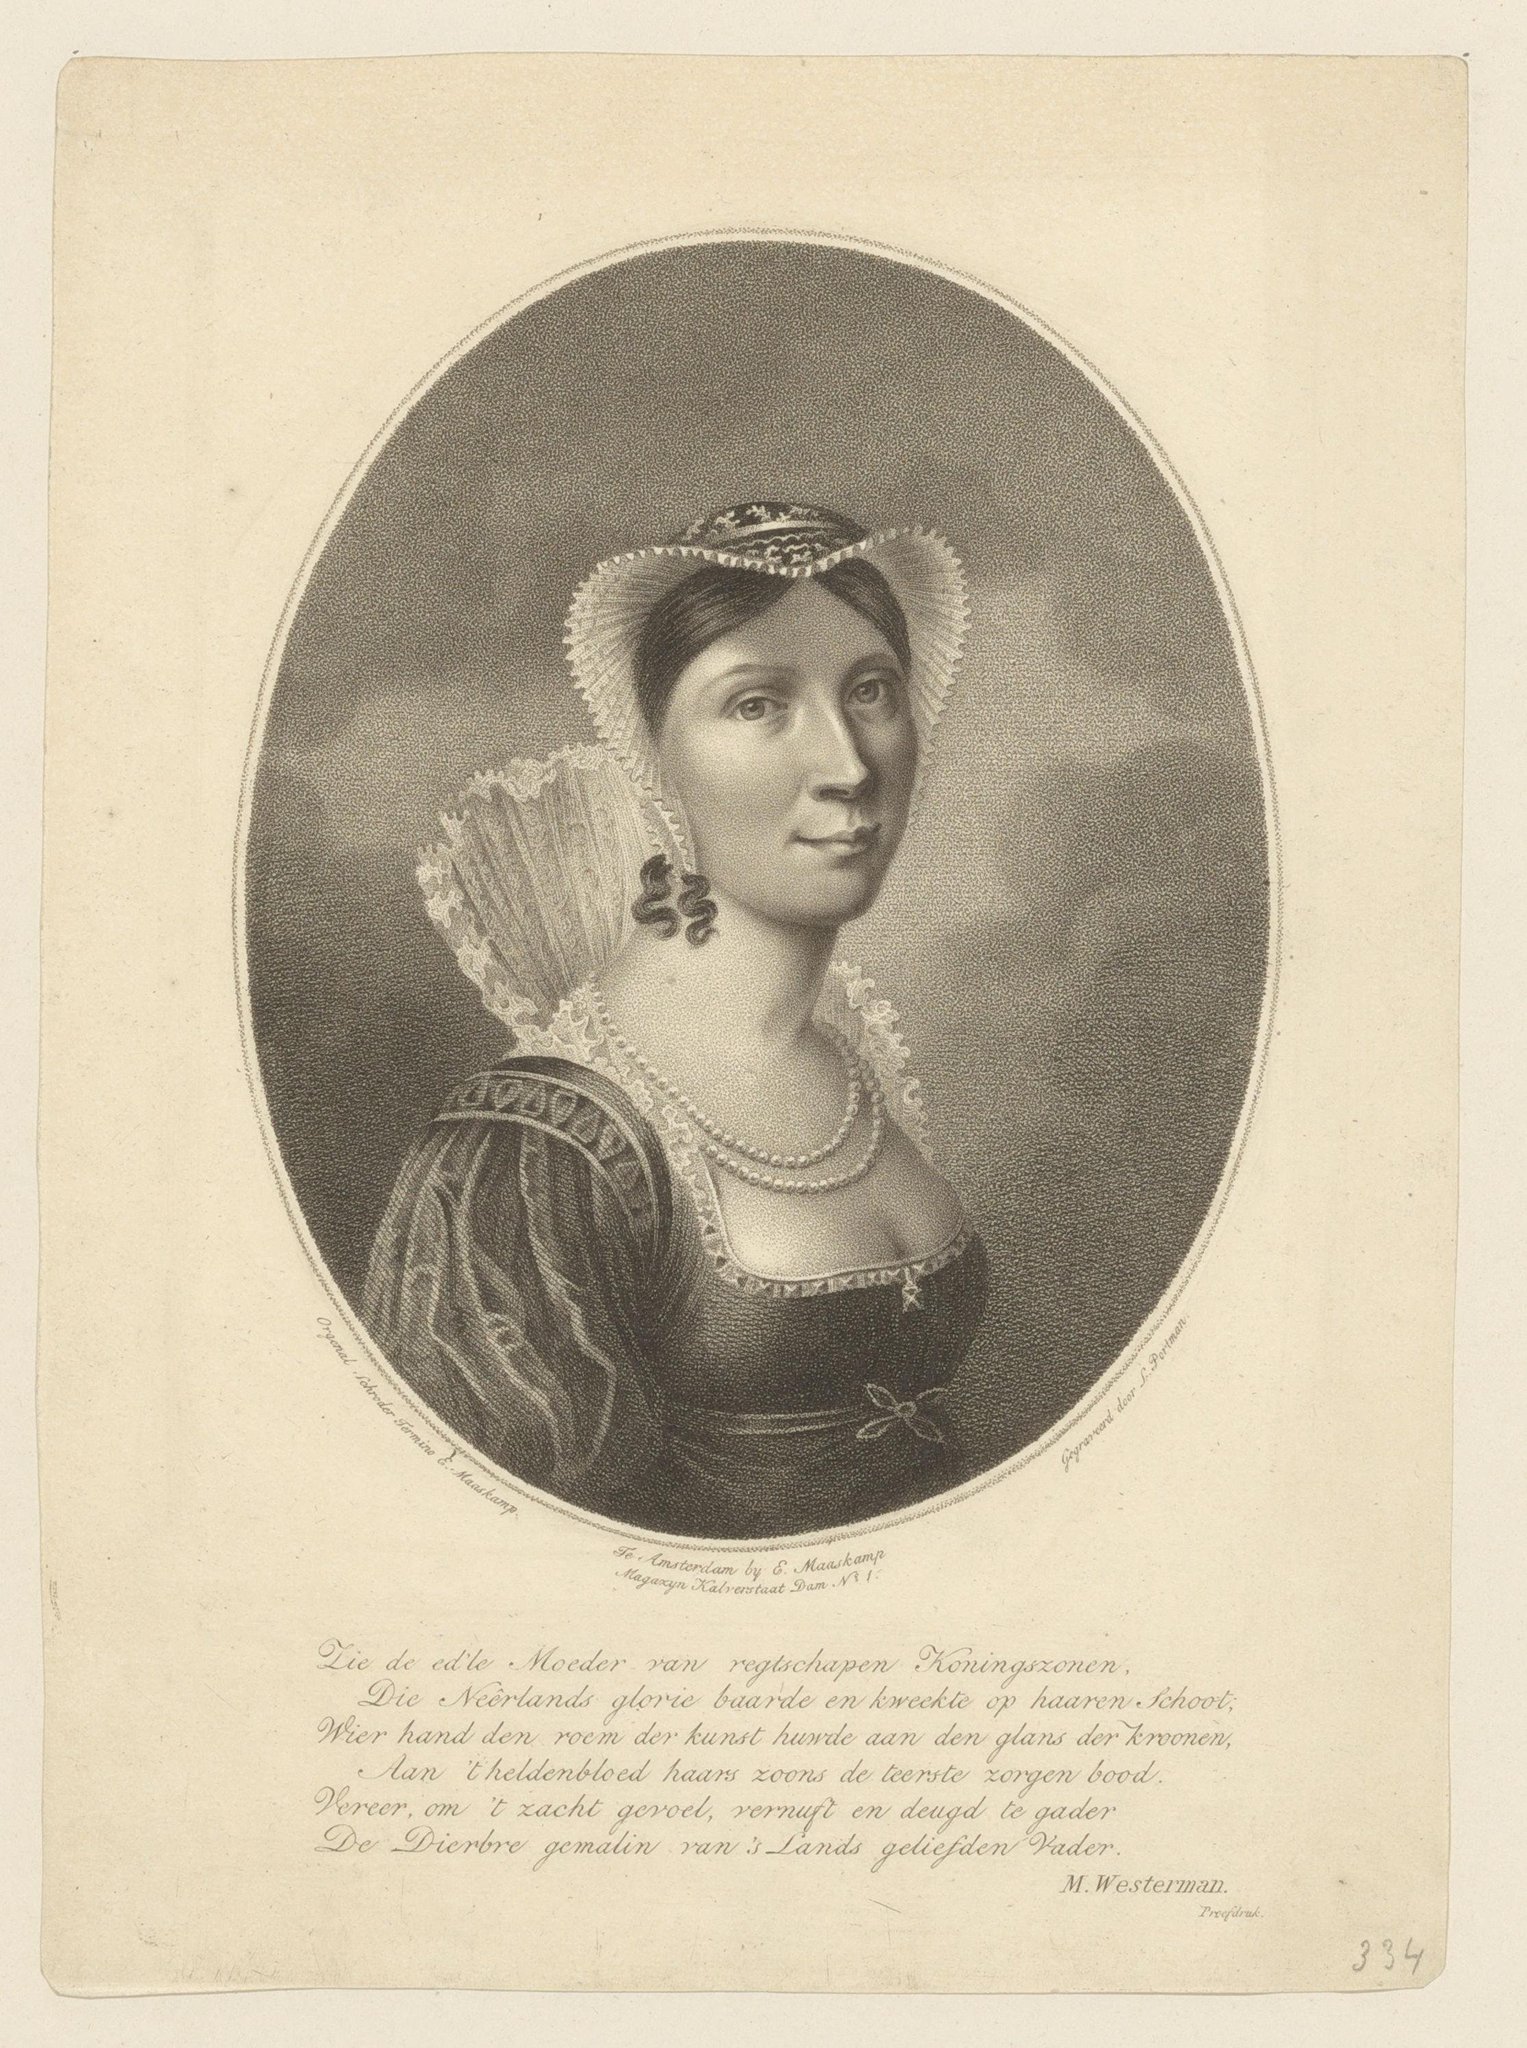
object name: print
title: Portret van Wilhelmina van Pruisen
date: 1815-1834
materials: paper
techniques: engraving, etching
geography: amsterdam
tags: berlin, the hague, wilhelmina frederica louisa (koningin der nederlanden), historical persons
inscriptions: stamp, collector's mark: Lugt 1641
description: Portret van Wilhelmina in een ovaal. In de ondermarge zes regels Nederlandse tekst. Onderwerpsrubrieken binnen de Atlas Zeden en Gewoonten: Portretten, Portretten van Vorsten uit het huis van Oranje, Regeerende Vorsten, Koningen uit het huis van Oranje.